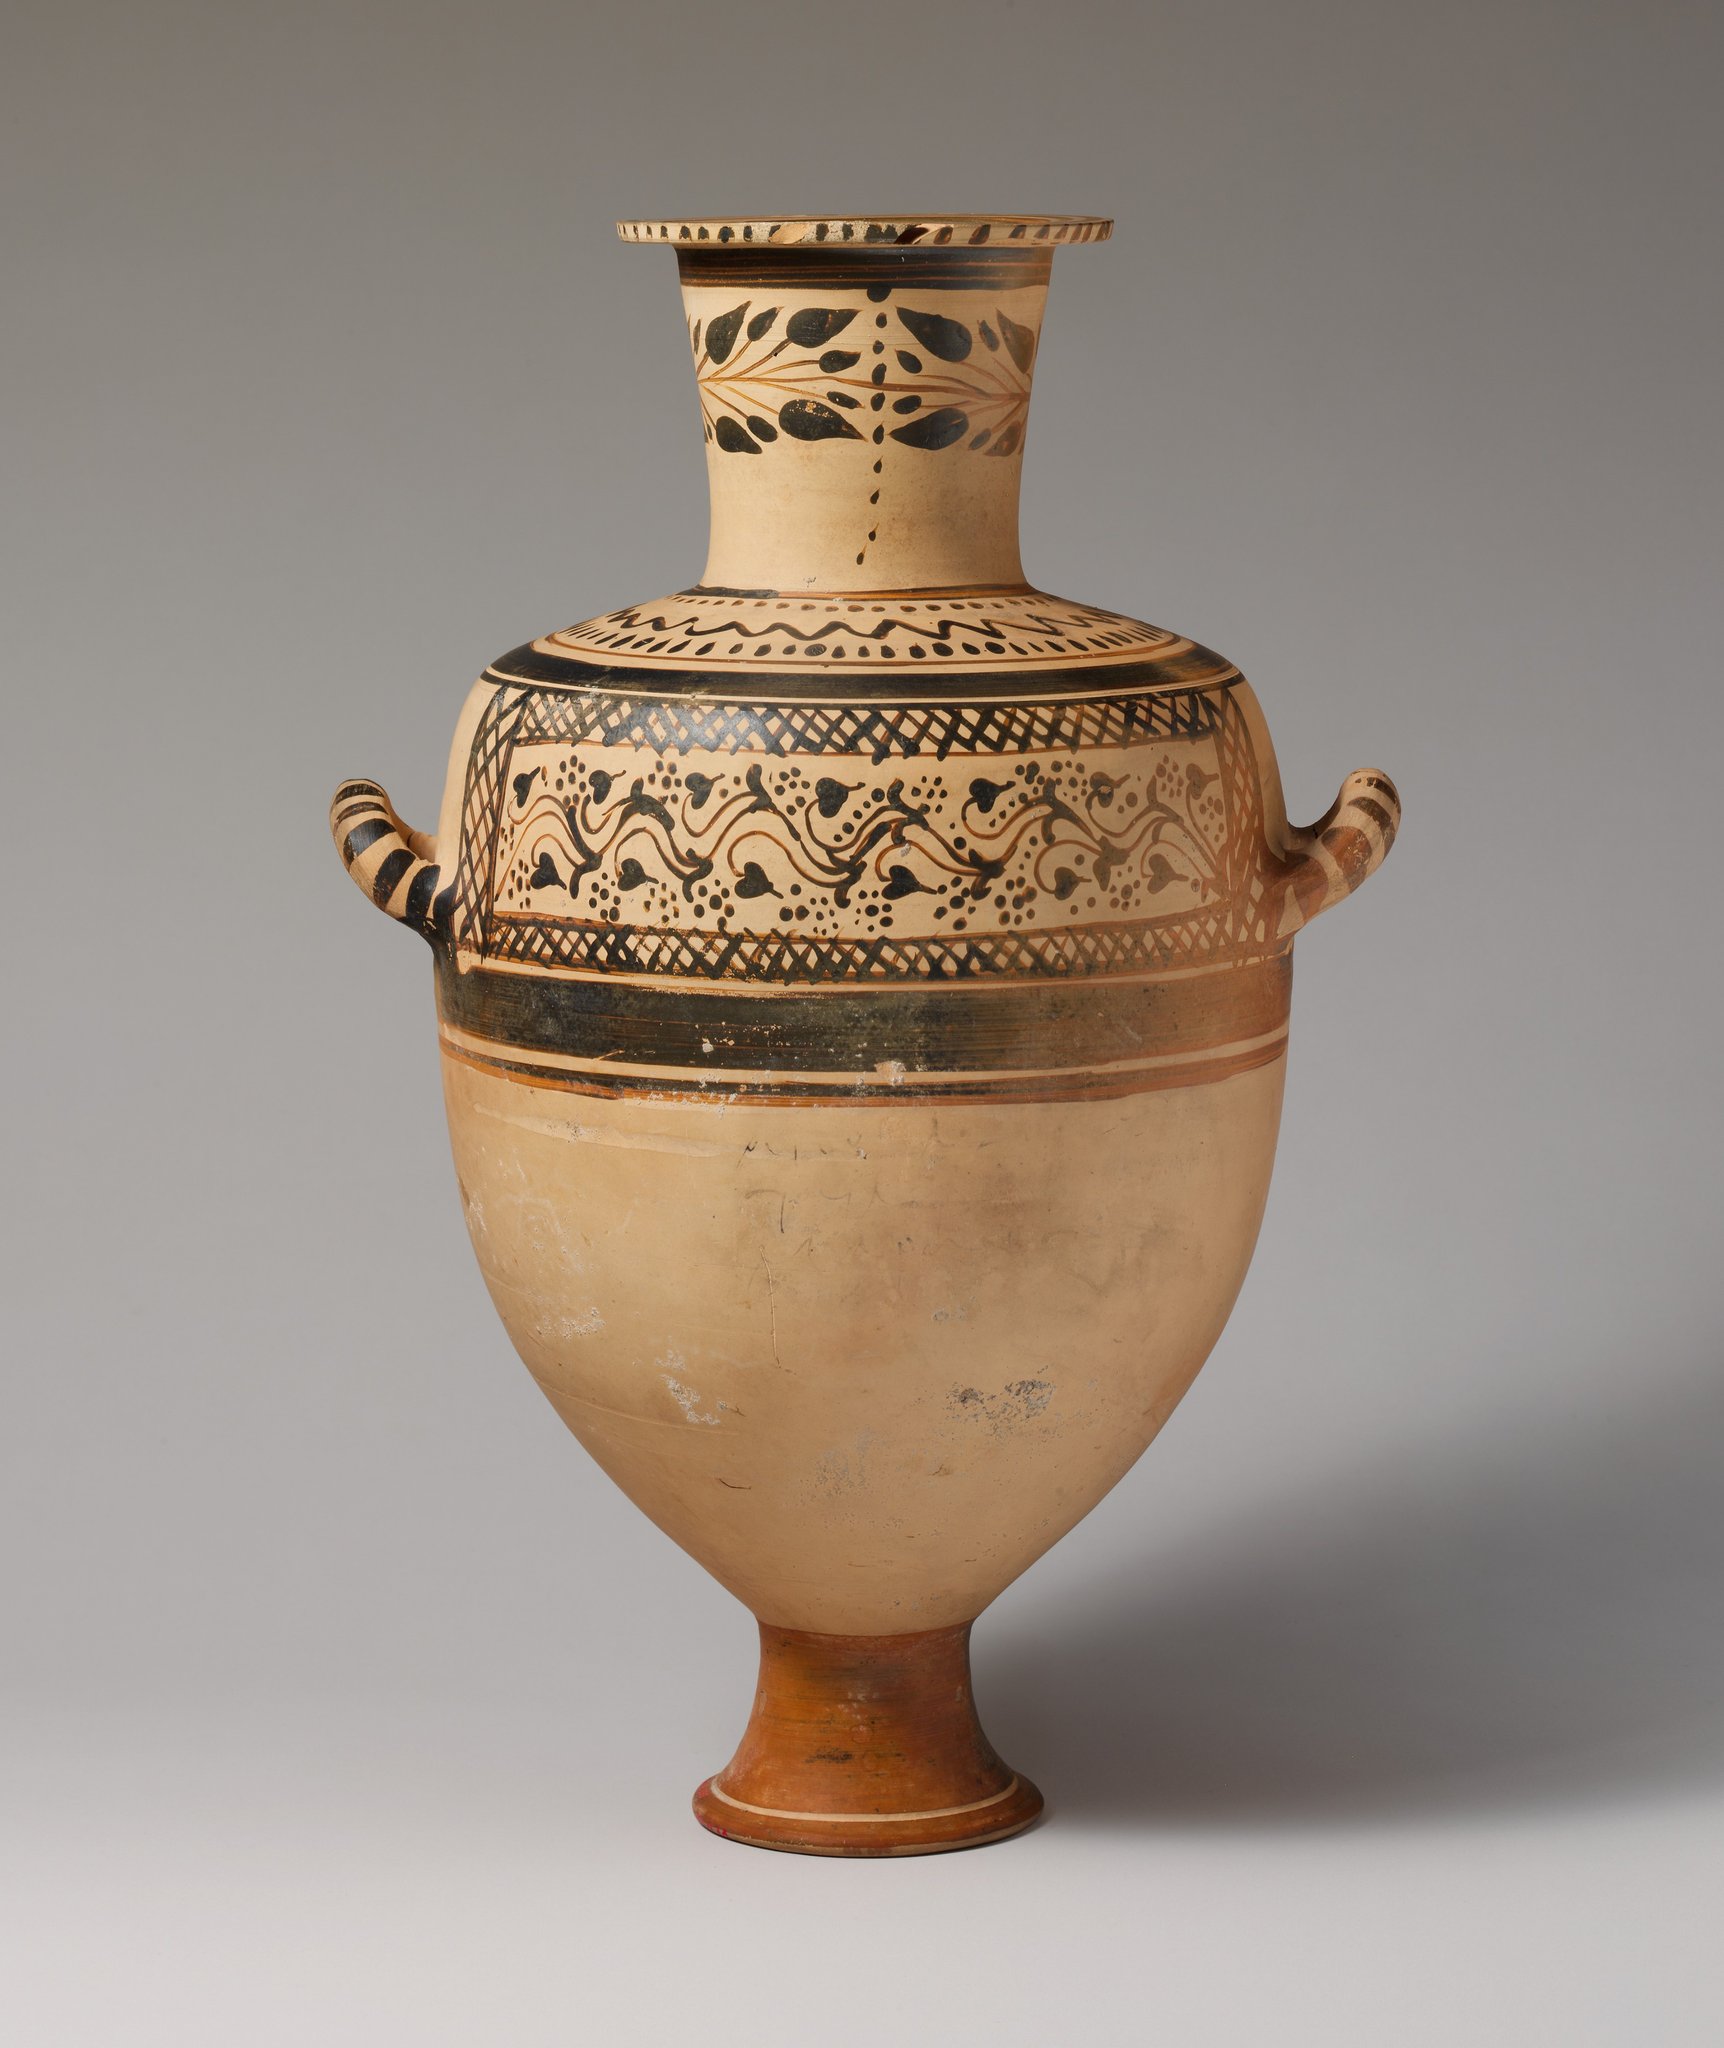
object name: hydria, hadra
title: Terracotta Hadra hydria (water jar)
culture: greek, cretan or ptolemaic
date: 234-201 BCE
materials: terracotta